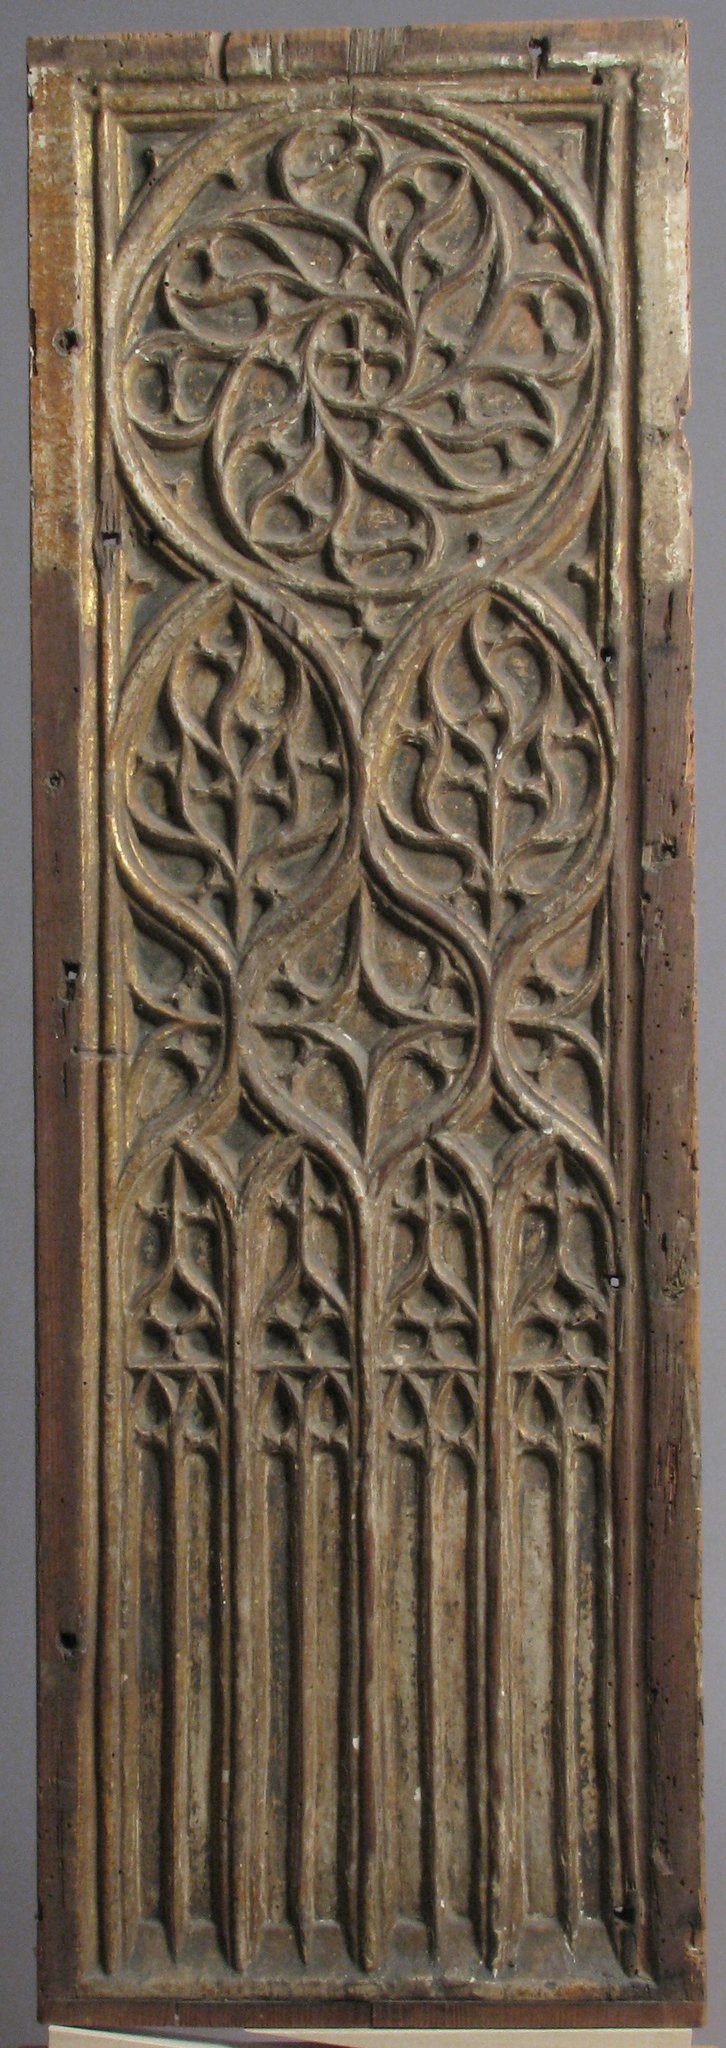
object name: panel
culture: french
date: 1467-1500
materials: wood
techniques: gilding, polychromy